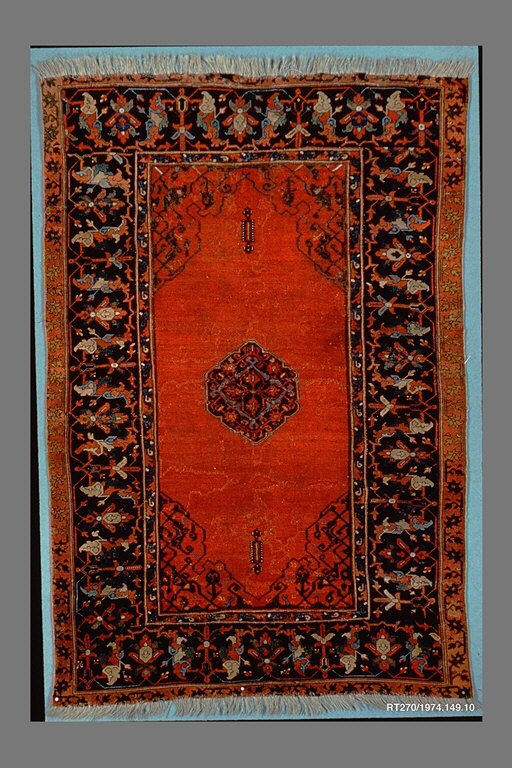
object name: carpet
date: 1601-1700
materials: wool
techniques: pile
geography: turkey